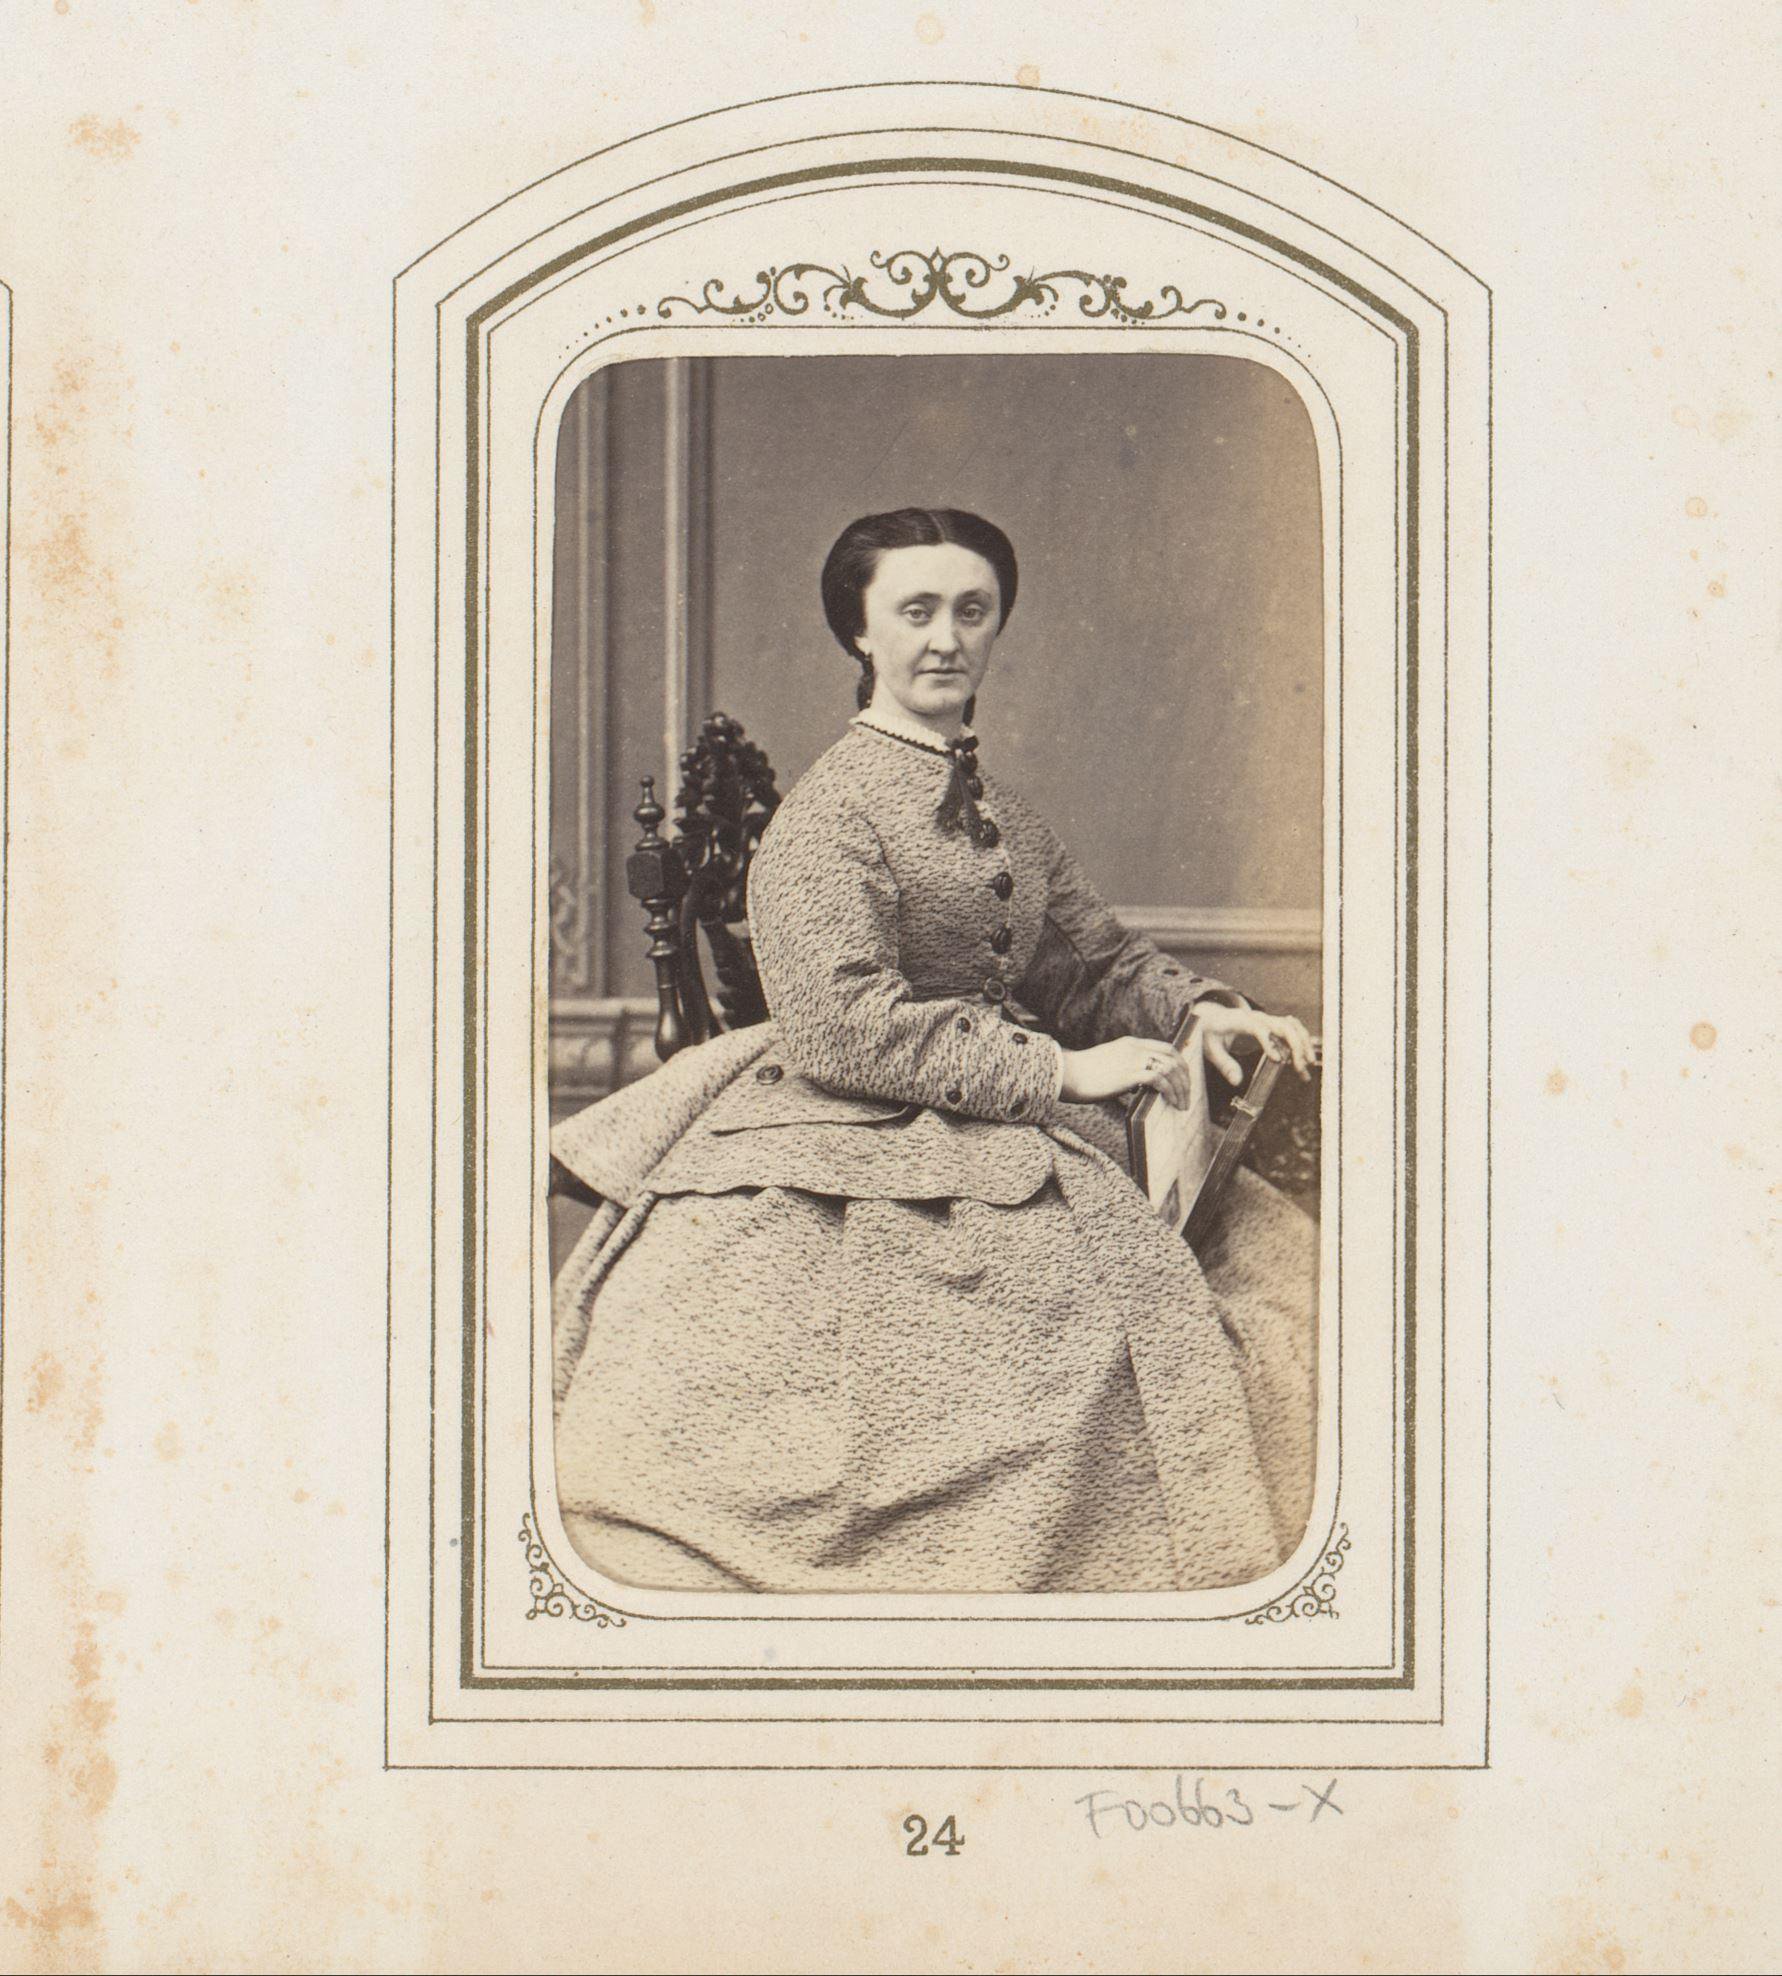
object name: carte de visite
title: Portret van een zittende vrouw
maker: eduard fuchs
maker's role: painter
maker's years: 1832-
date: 1860-1870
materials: cardboard, photographic support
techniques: albumen print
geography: leeuwarden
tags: historical persons - bb - woman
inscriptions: number: ‘24’, number: ‘663-x’, inscription: ‘Photographie/ E. Fuchs/ Leeuwarden’